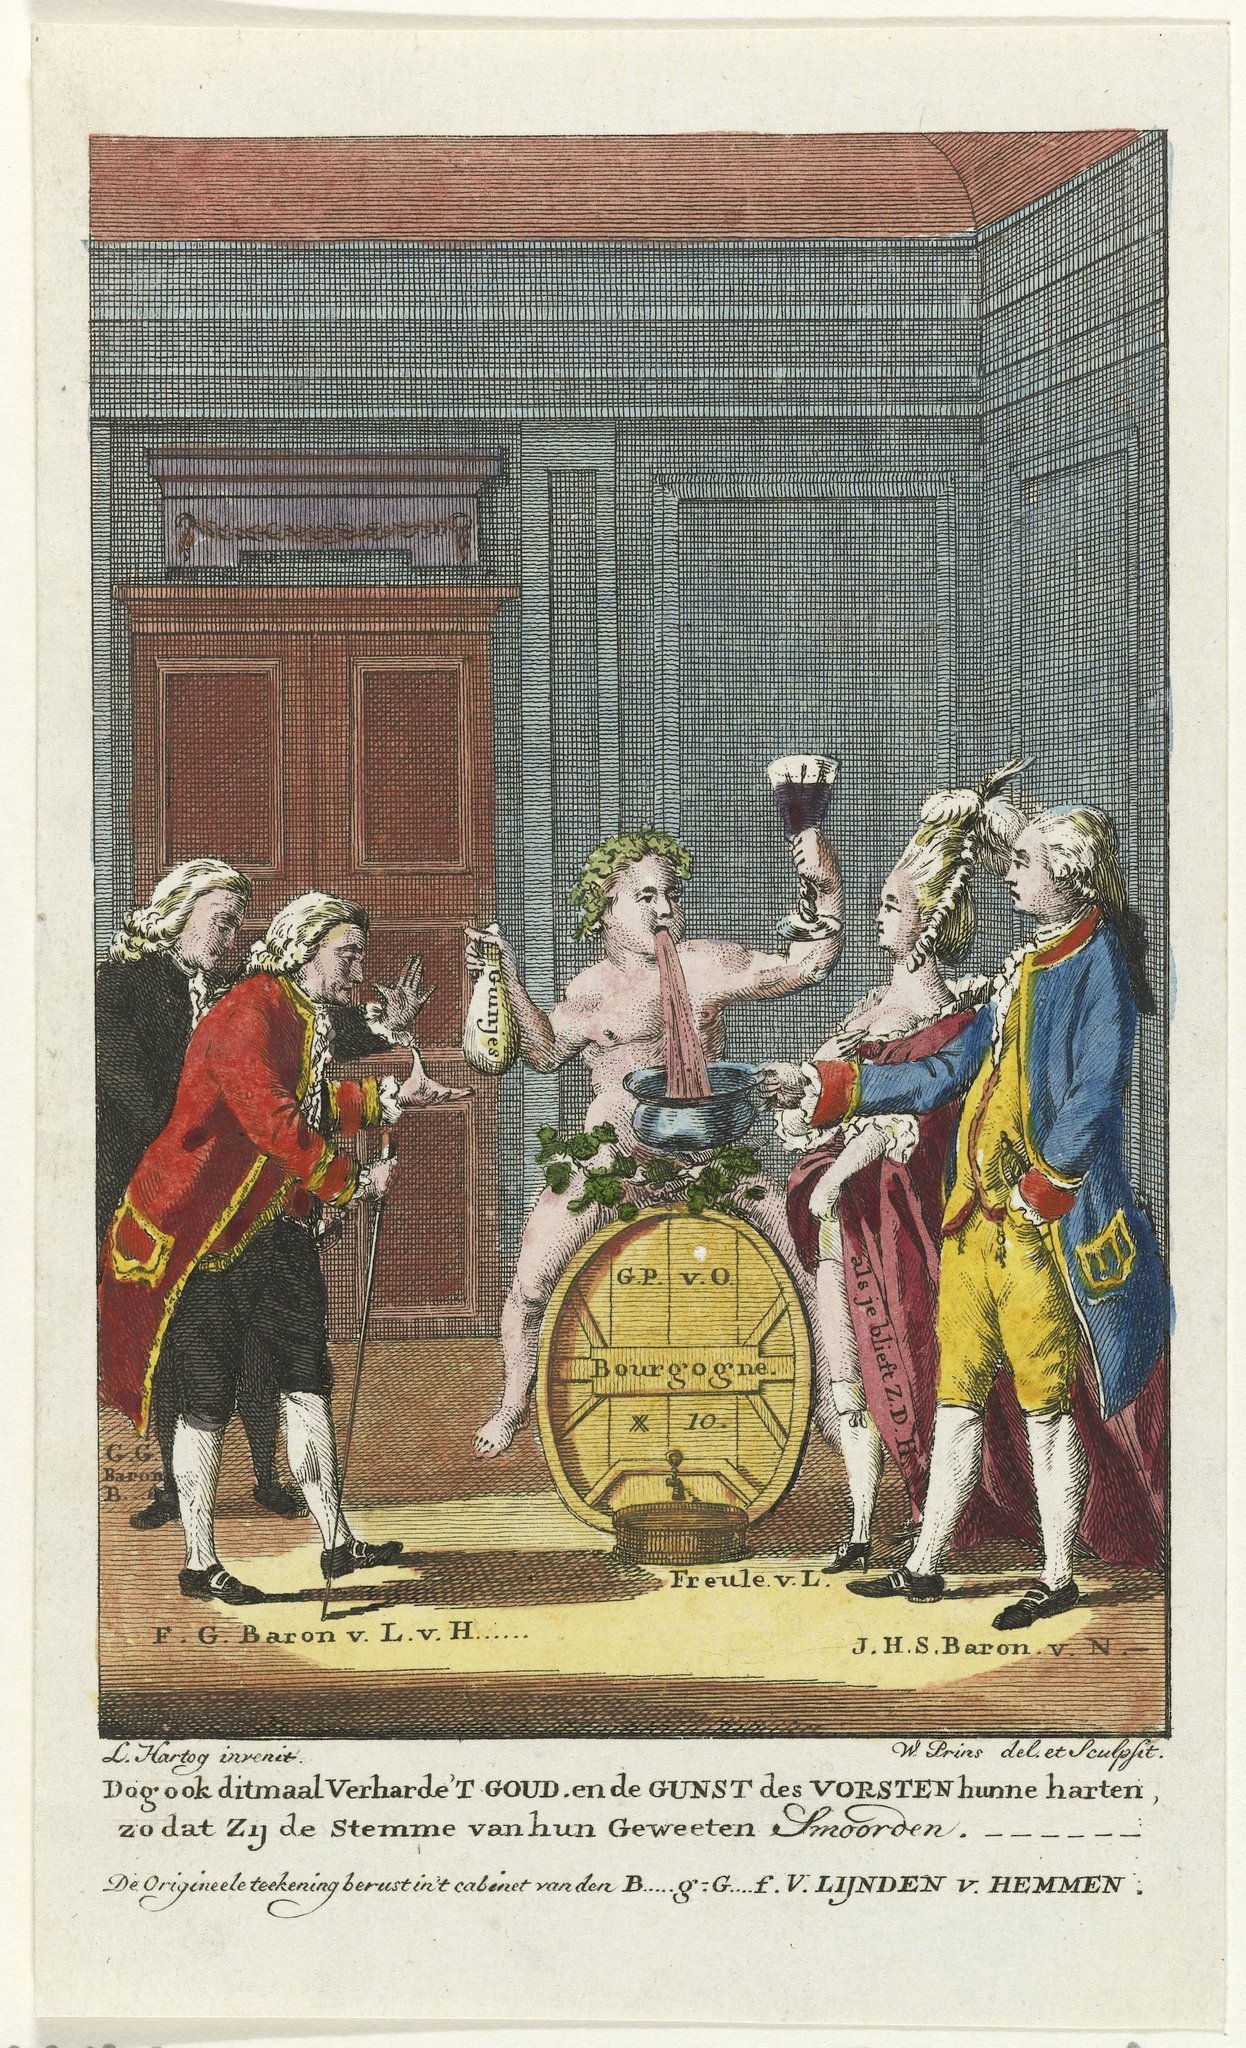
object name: cartoon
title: Spotprent op prins Willem V als brakende Bacchus, 1782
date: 1782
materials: paper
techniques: etching, hand coloring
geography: northern netherlands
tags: the hague, william v (prince of orange), ludwig ernst von braunschweig-wolfenbüttel, specific aspects, allegorical aspects of bacchus; bacchus as patron, political caricatures and satires, patriots (1780-1795)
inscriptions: collector's mark: Lugt 2228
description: Spotprent met prins Willem V als Bacchus naakt op een wijnvat zittend. De prins spuwt in een kamerpot die opgehouden wordt door de freule Constance van Lynden van Hoevelaken die ook haar rokken optilt en haar diensten aanbiedt. Rechts J.H.S. Baron van Nagell, links Frans Godard Baron van Lynden van Hemmen en G.G. Baron Bentinck. Met drieregelig onderschrift en gefingeerde signaturen. Titelprent uit een pamflet.